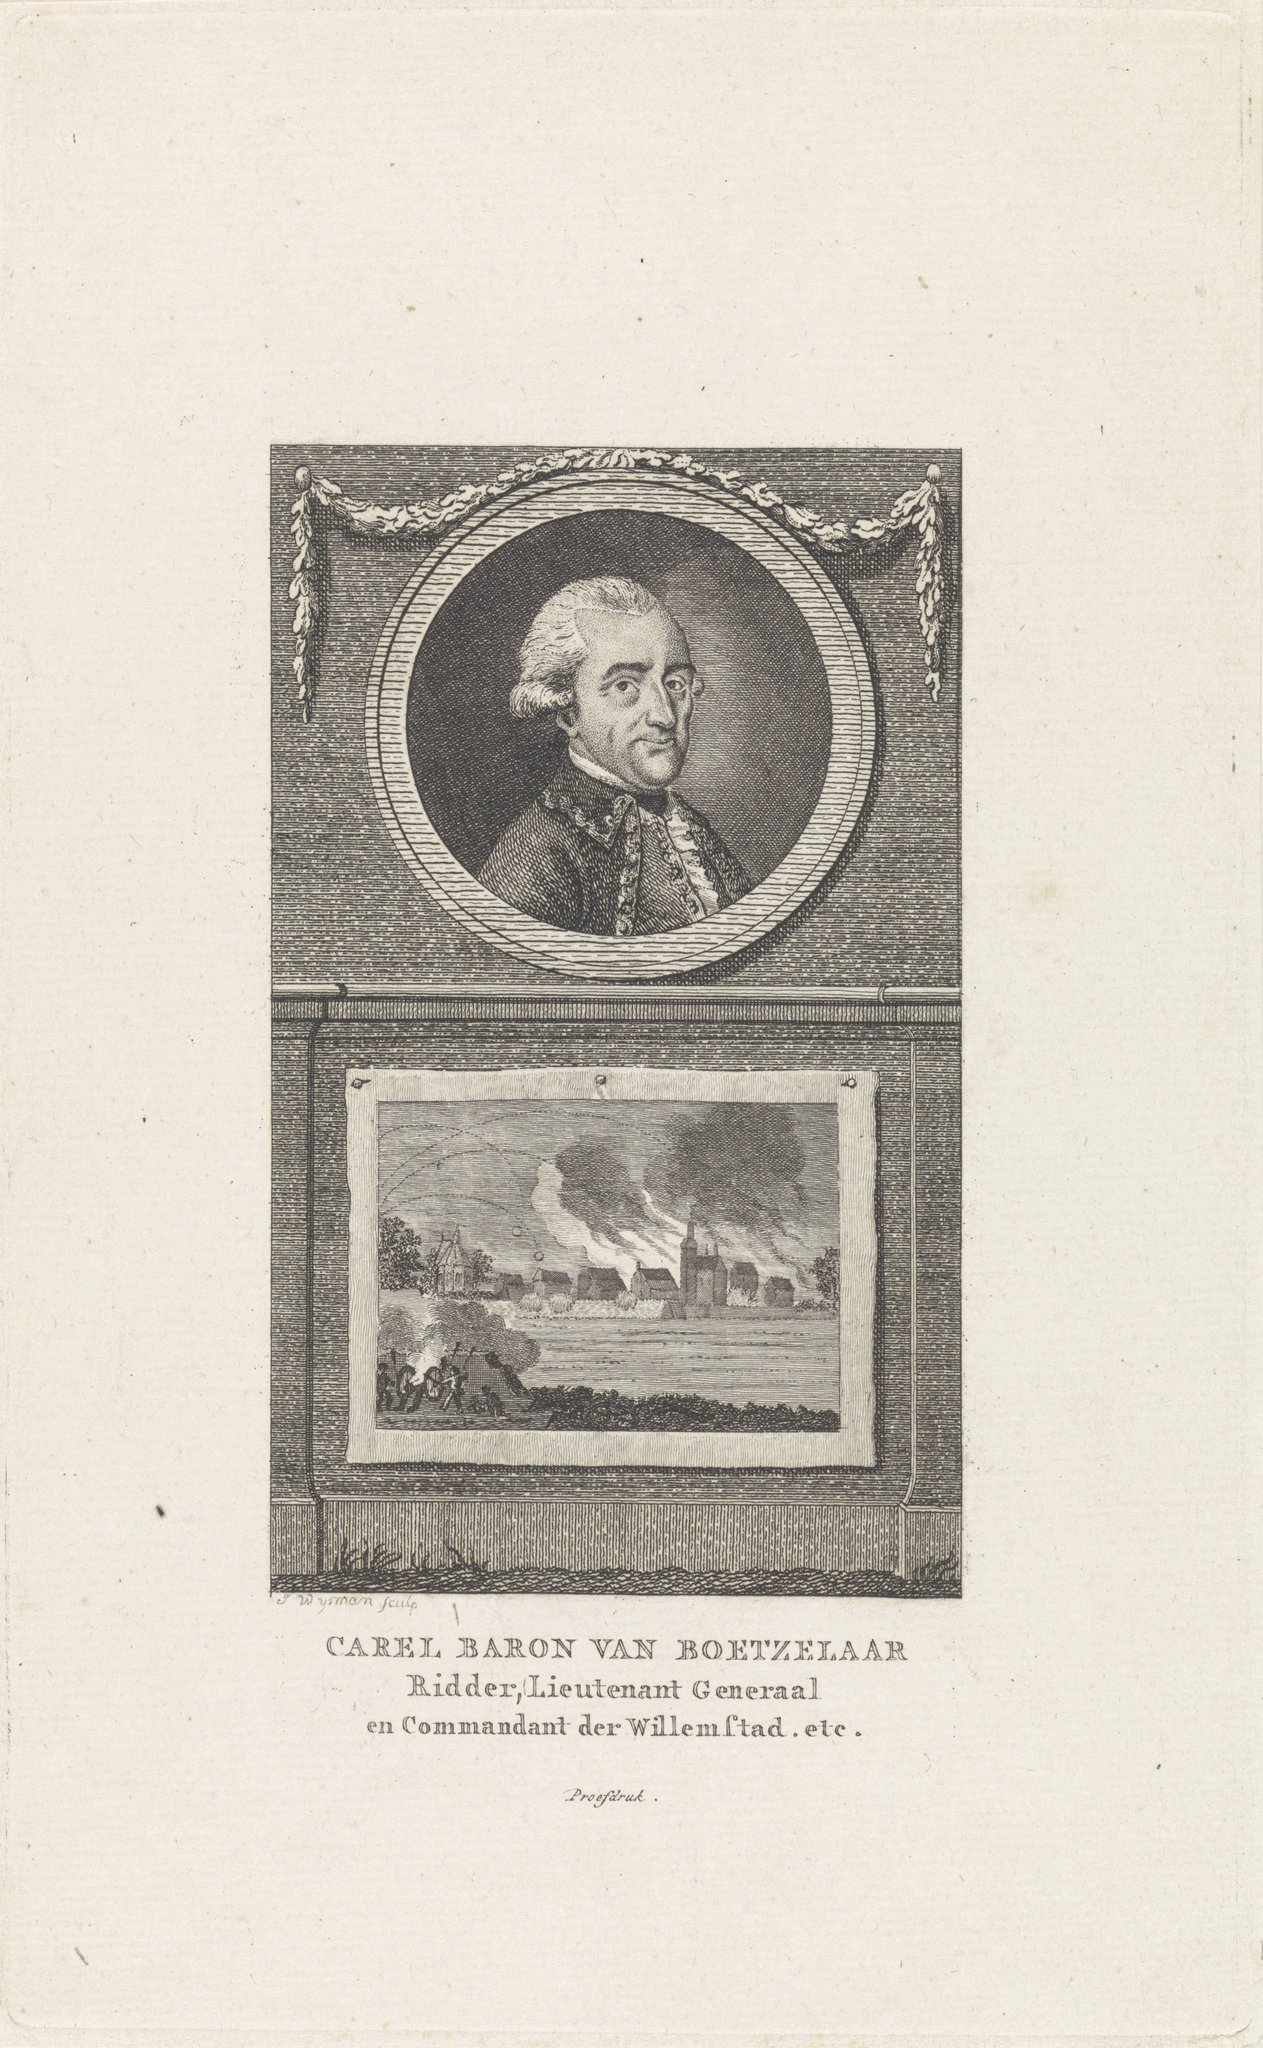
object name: print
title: Portret van Carel baron van Boetzelaar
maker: jacobus wijsman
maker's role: print maker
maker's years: 1768-1827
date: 1793-1827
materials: paper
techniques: engraving, etching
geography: amsterdam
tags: the hague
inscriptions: collector's mark: Lugt 2228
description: Portret van Carel baron van Boetzelaar in een ronde lijst. Onder het portret een opgeprikte afbeelding van de belegering van Willemstad in 1793. Onder leiding van Carel baron van Boetzelaar werd de stad verdedigd en het Franse leger weerstaan.